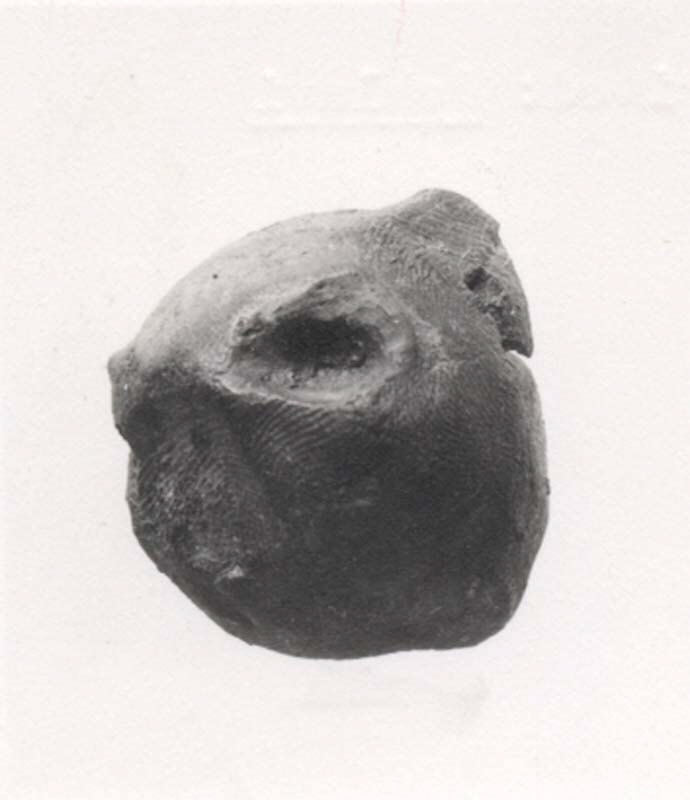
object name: sealing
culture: sasanian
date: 601-700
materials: clay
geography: iran